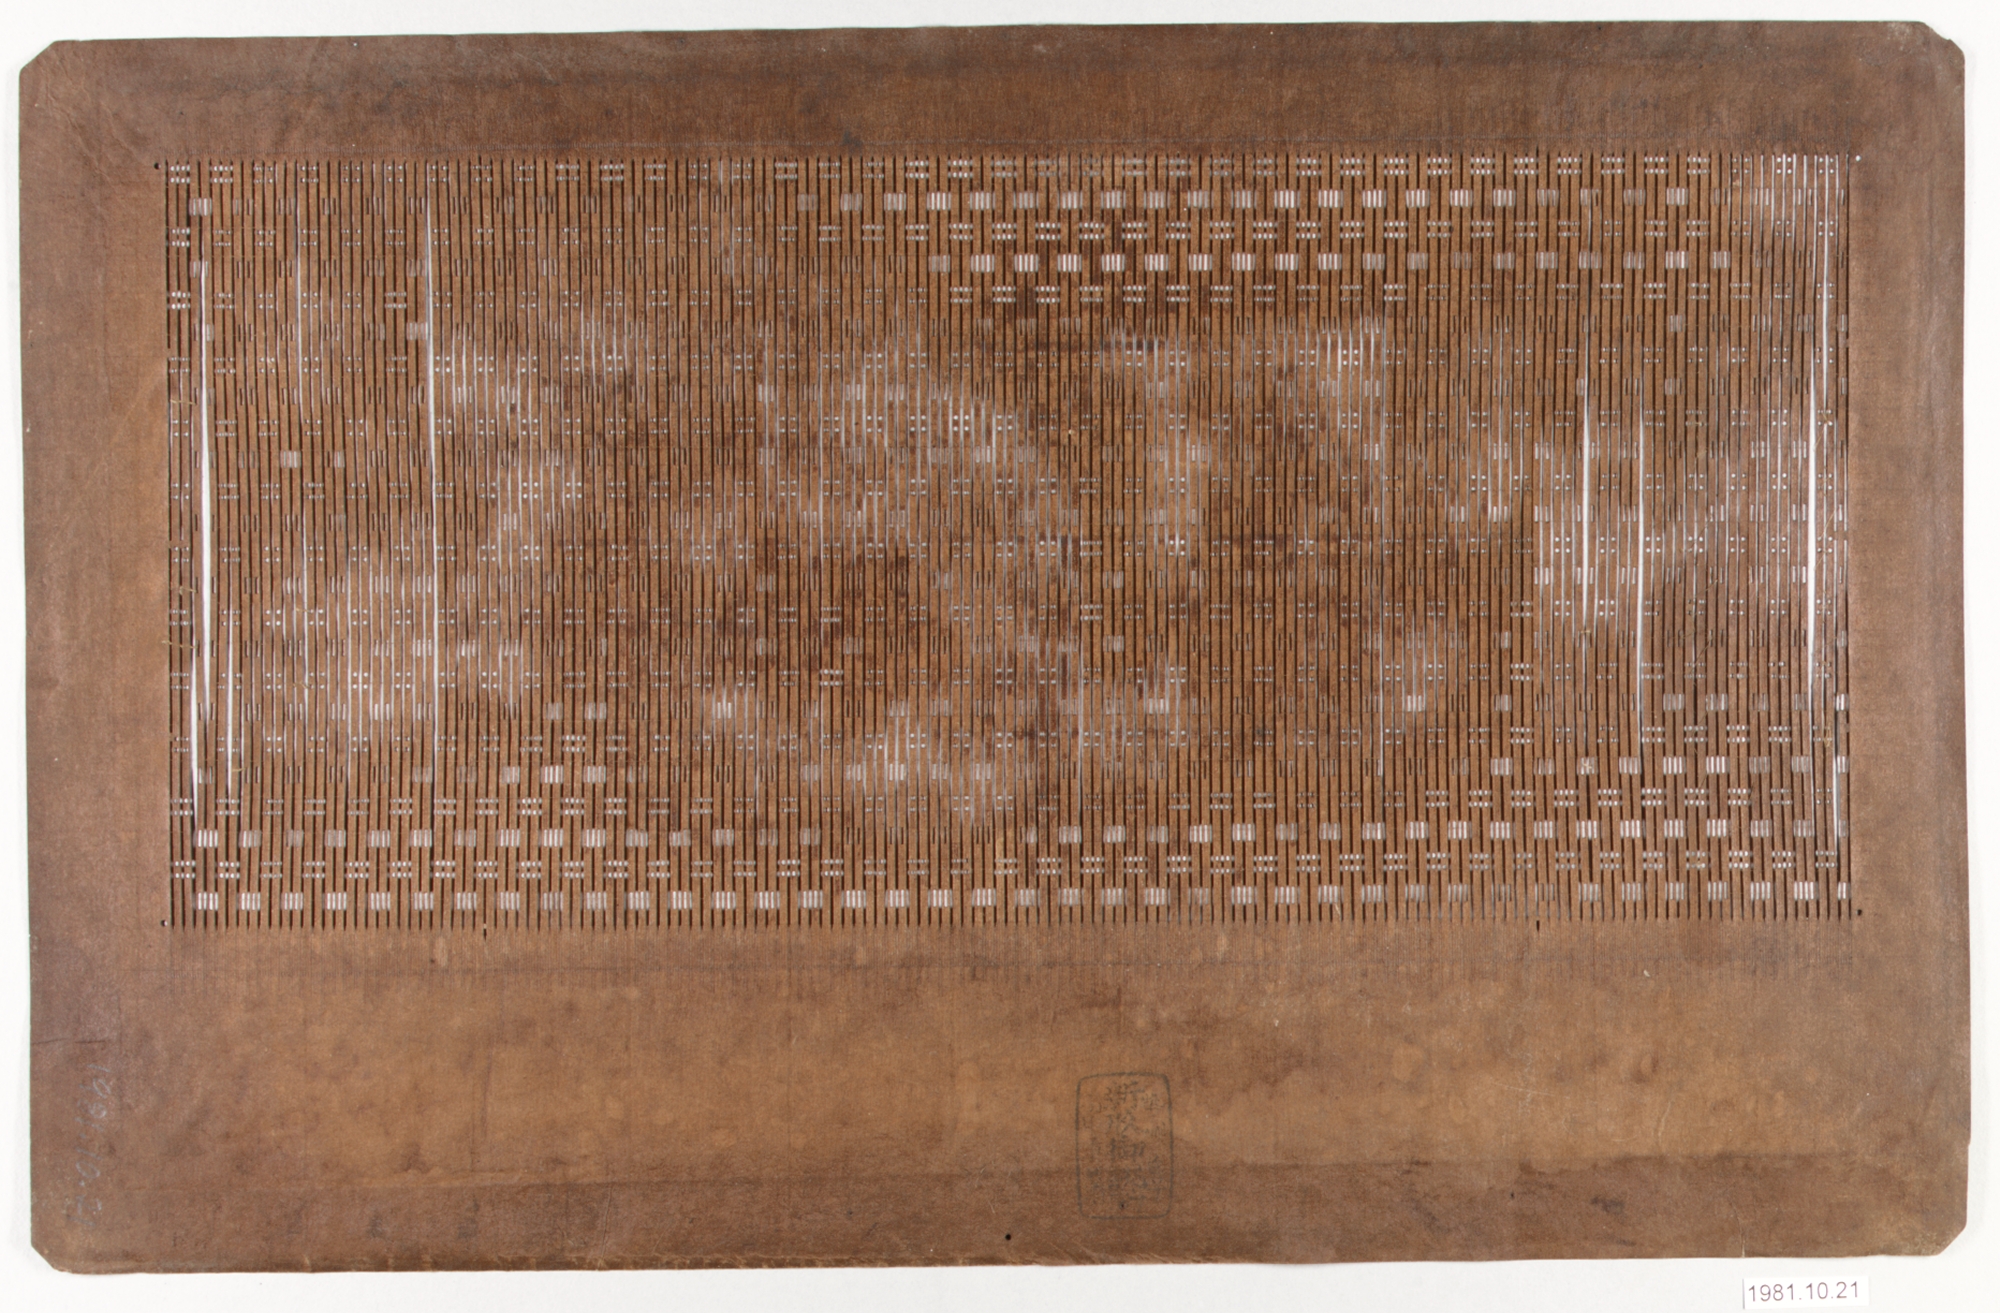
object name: stencil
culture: japanese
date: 1801-1900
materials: paper